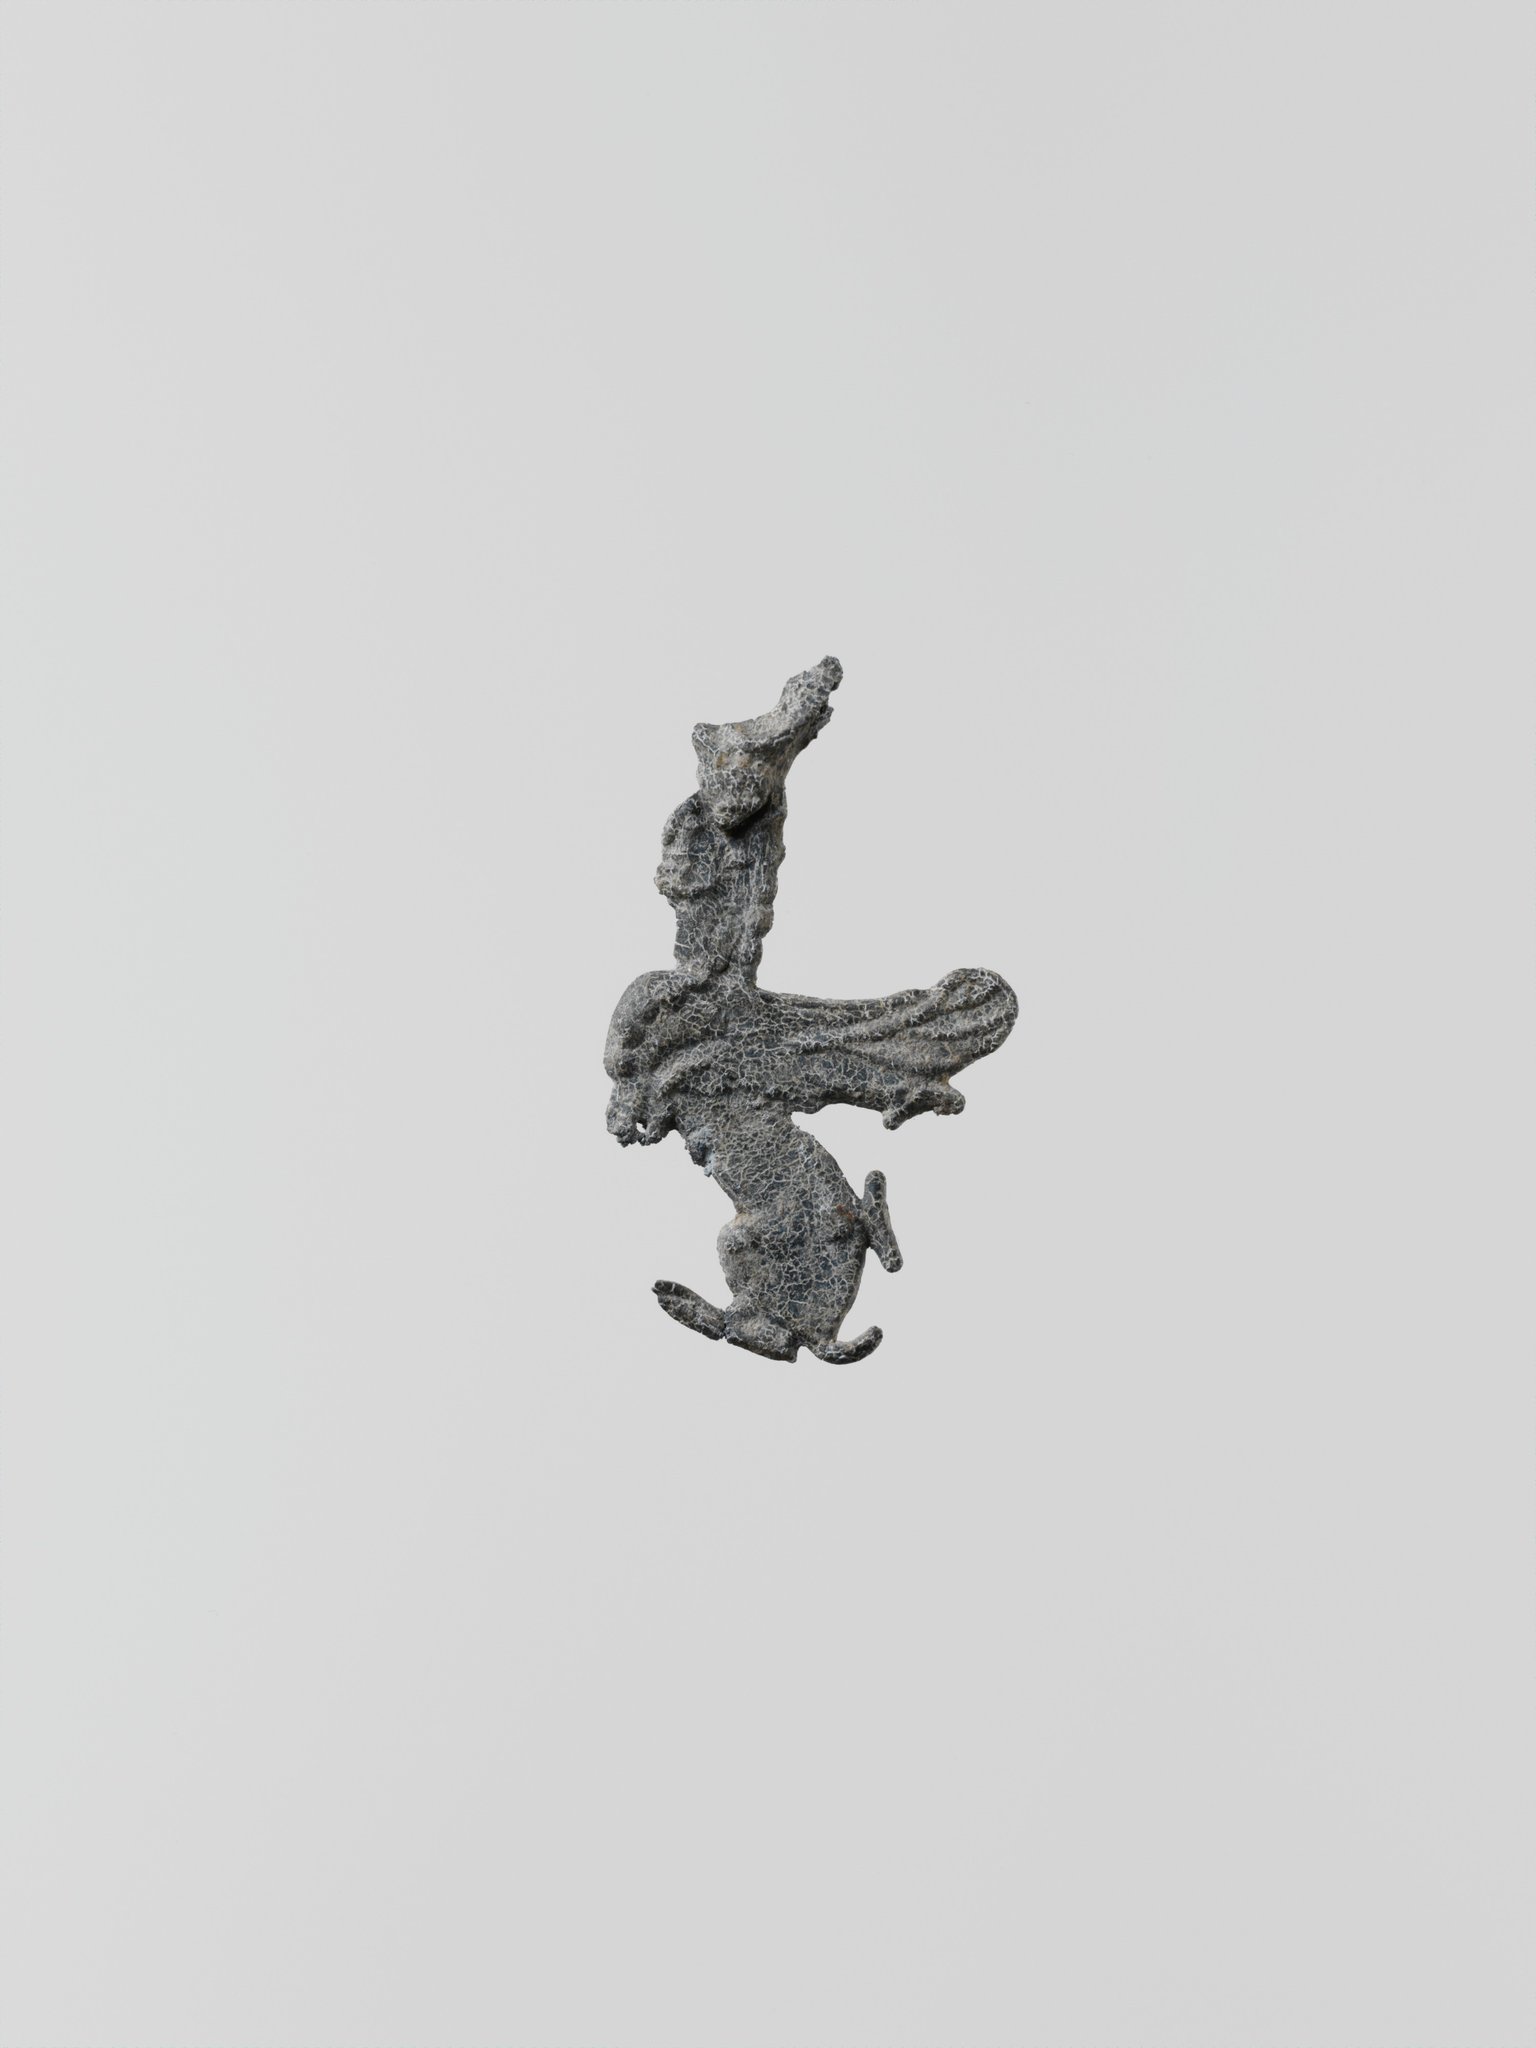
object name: statuette of a sphinx, 5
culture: greek, laconian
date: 7000-30 BCE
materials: lead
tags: sphinx